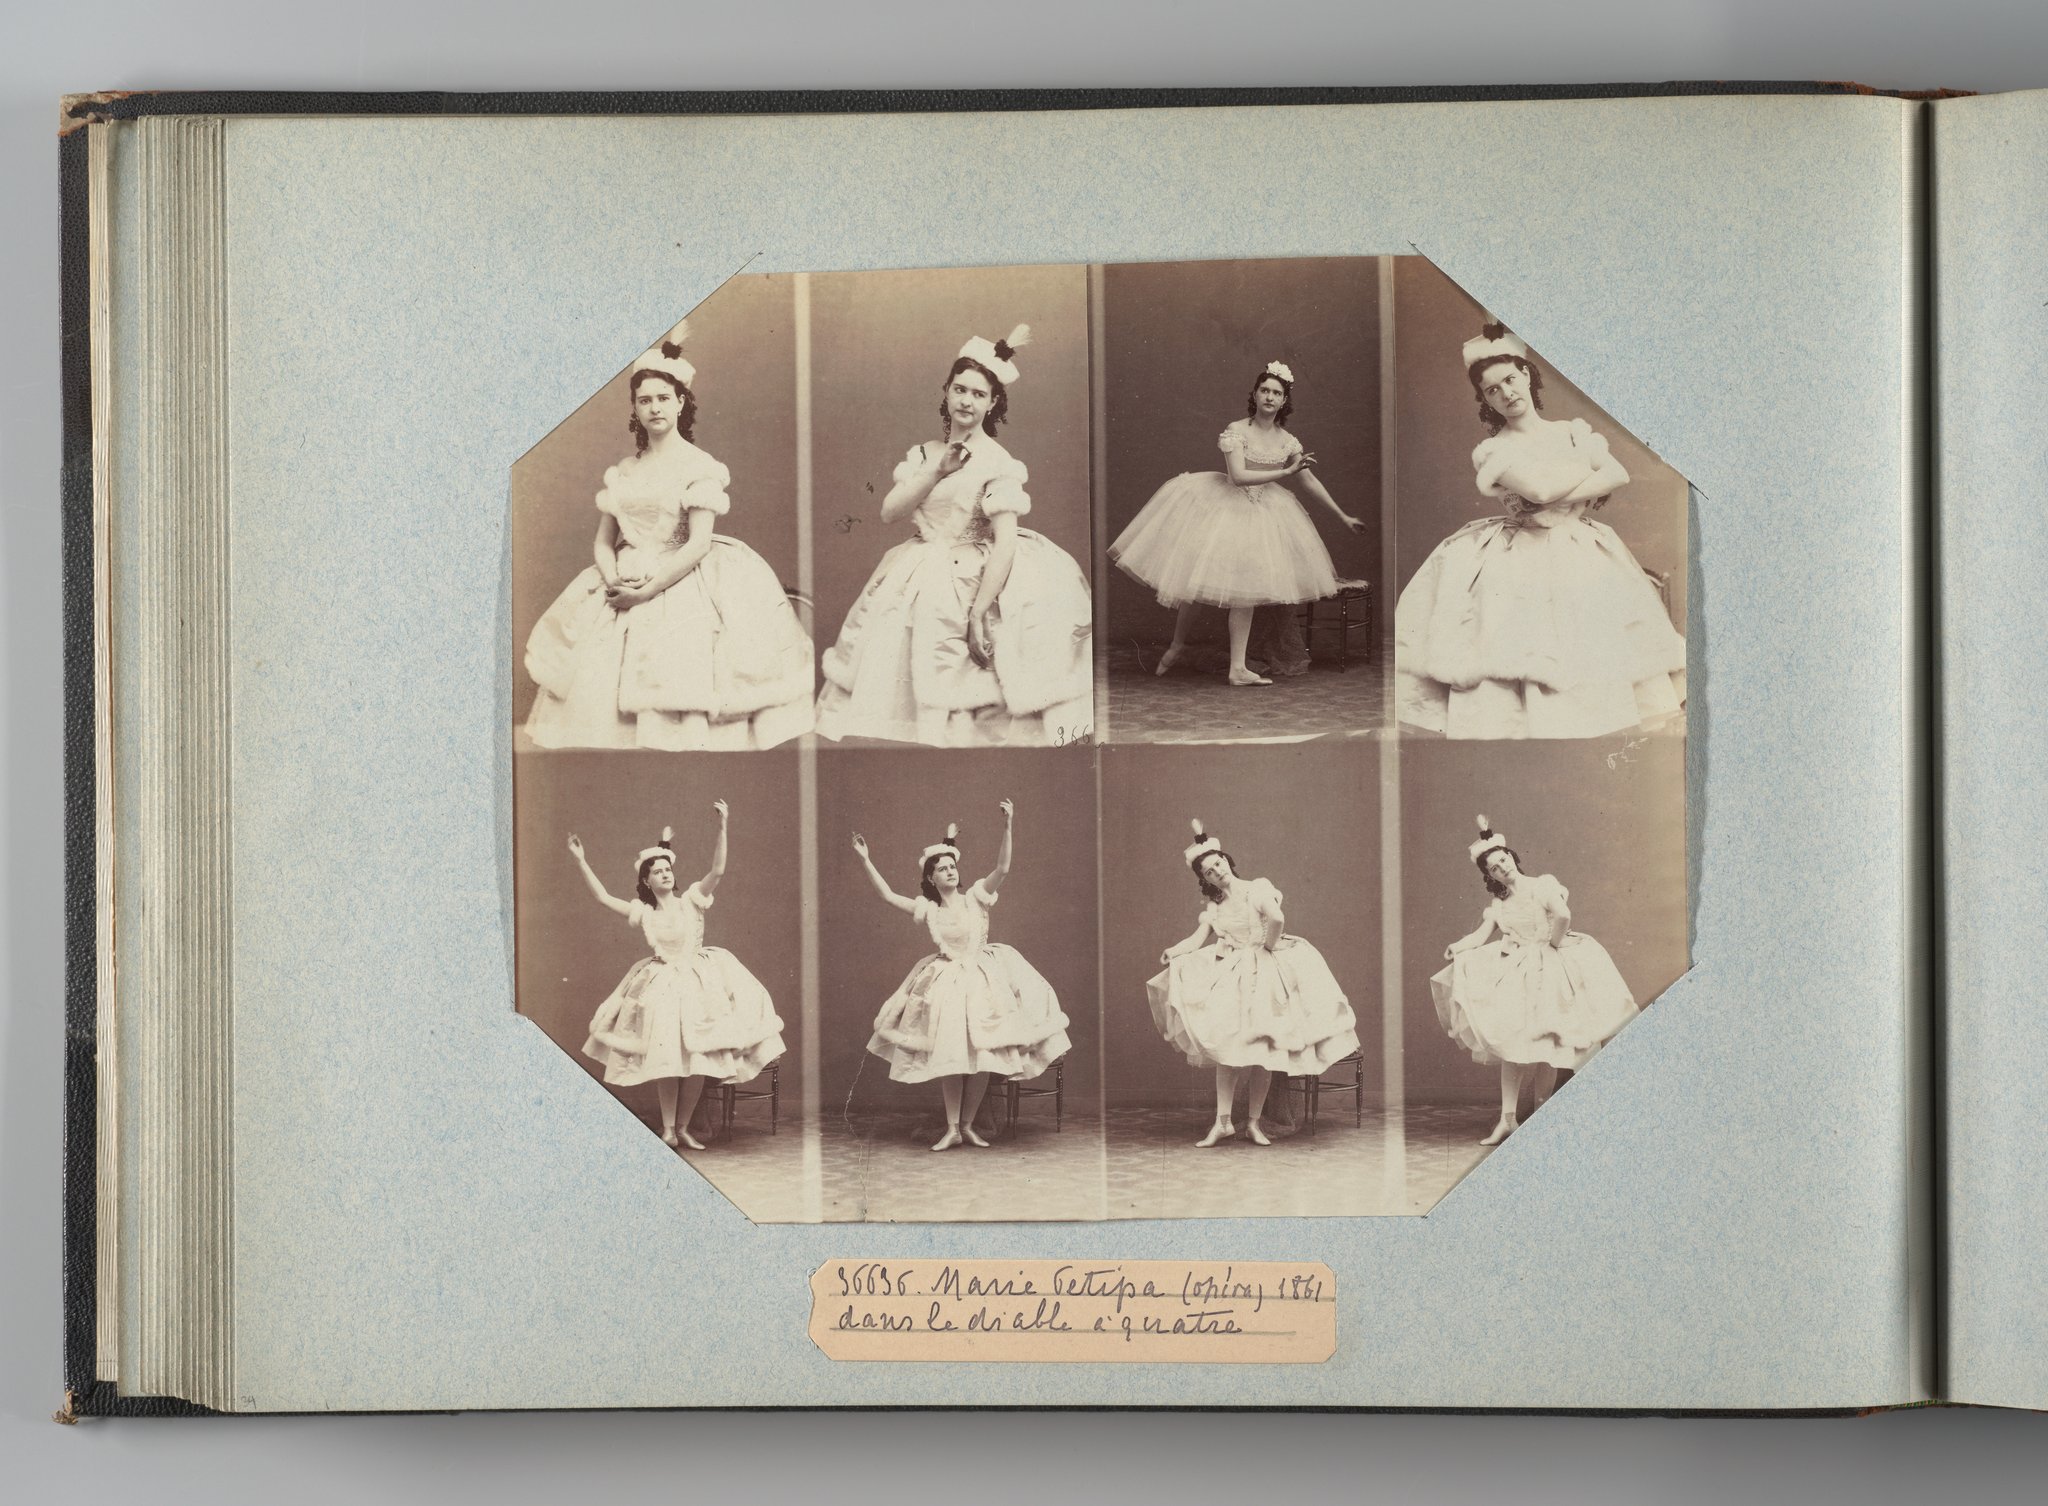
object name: photograph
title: Marie Petipa dans le Diable à quatre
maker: andré-adolphe-eugène disdéri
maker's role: artist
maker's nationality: french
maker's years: 1819-1889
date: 1861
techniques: albumen silver print, glass negative